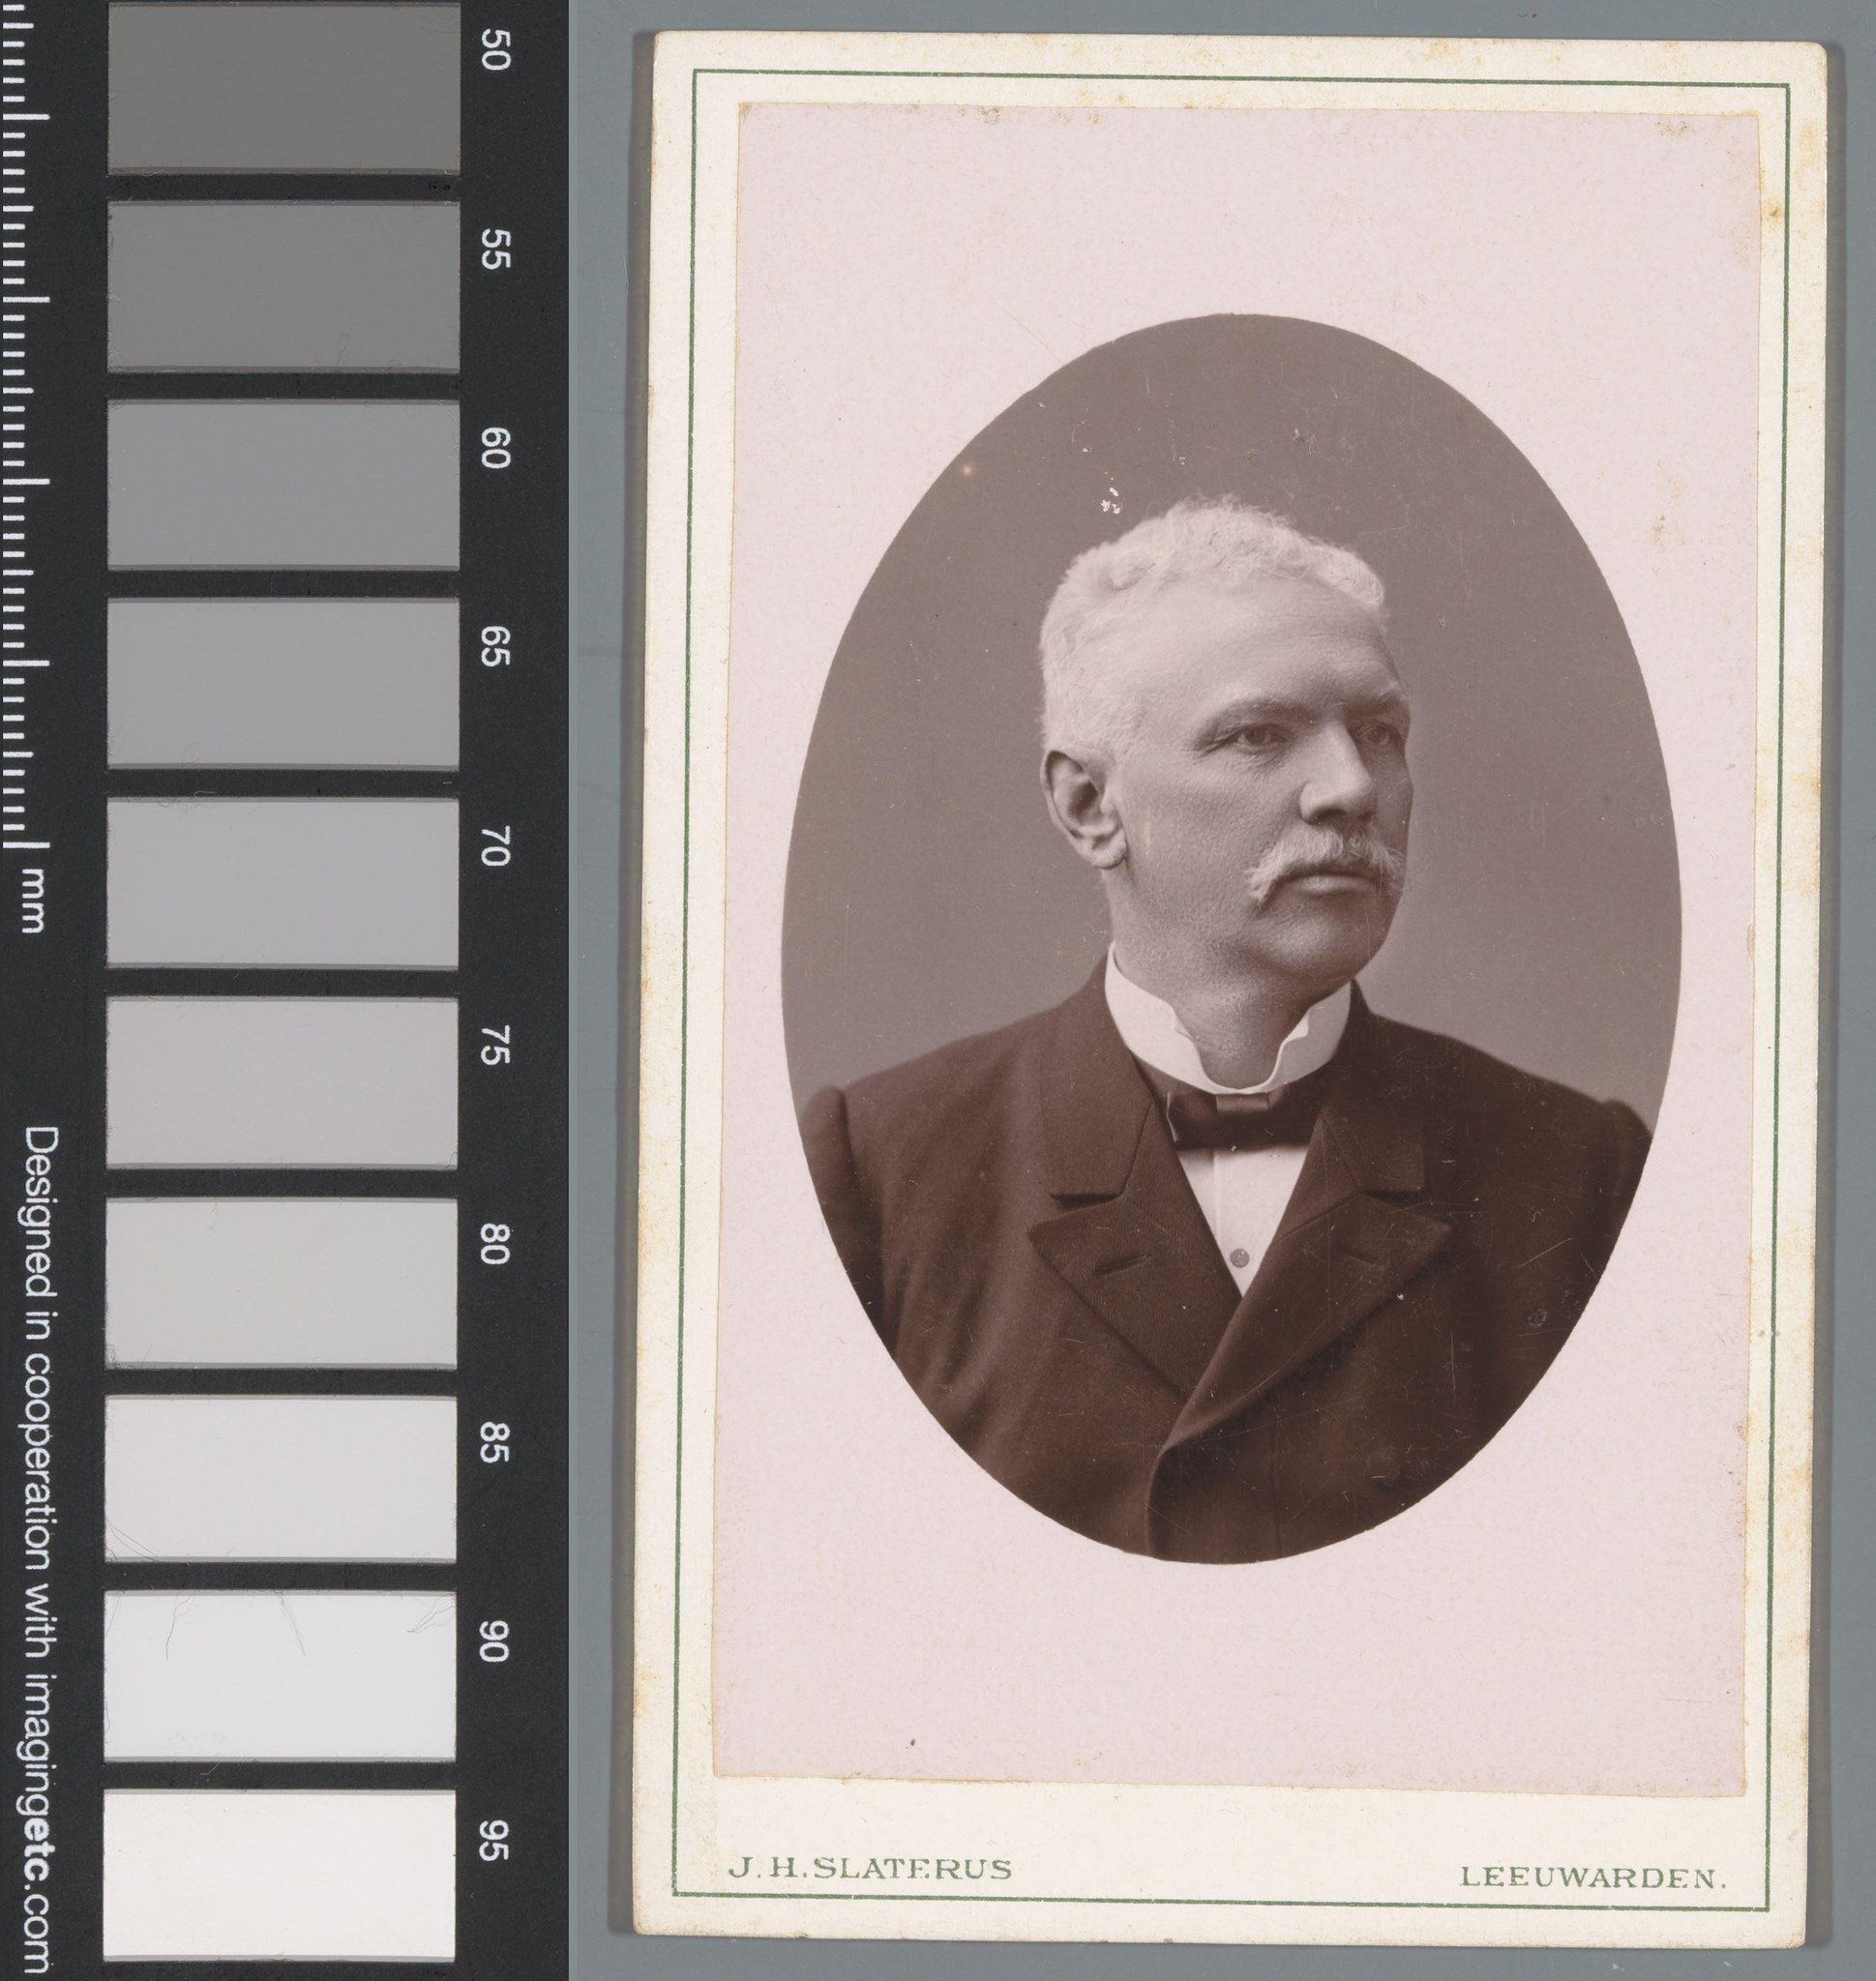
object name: photograph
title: Portret van een onbekende man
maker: idanus hendrikus slaterus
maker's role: fotograaf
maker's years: 1846-1921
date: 1892-1909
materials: cardboard, photographic support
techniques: gelatin silver print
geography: leeuwarden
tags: adult man, historical persons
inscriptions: inscription: ‘Photographie Instantanée/ J. H. SLATERUS/ Langemarktstraat/ tegenover het Station bij de/ nieuwe Veemarkt/ Let. W. No. 14./ LEEUWARDEN.’